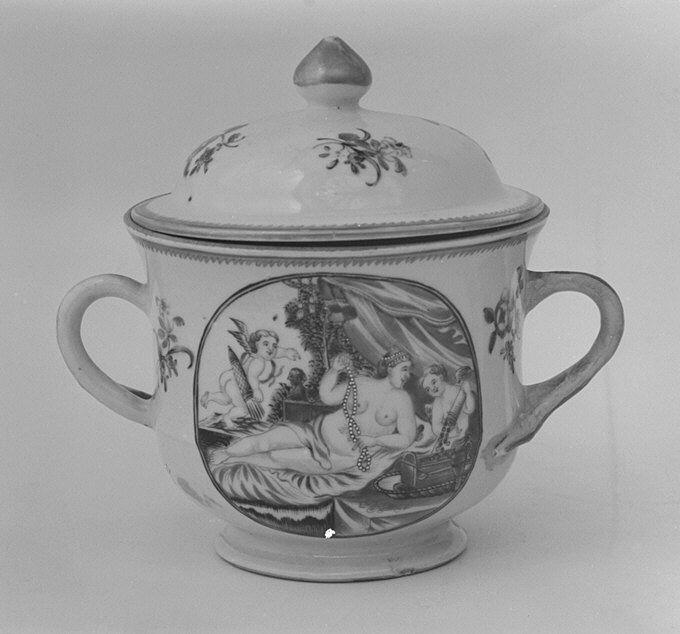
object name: sugar bowl with cover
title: Sugar bowl with cover (part of a service)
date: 1750-1770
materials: hard paste porcelain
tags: female nudes,cupid